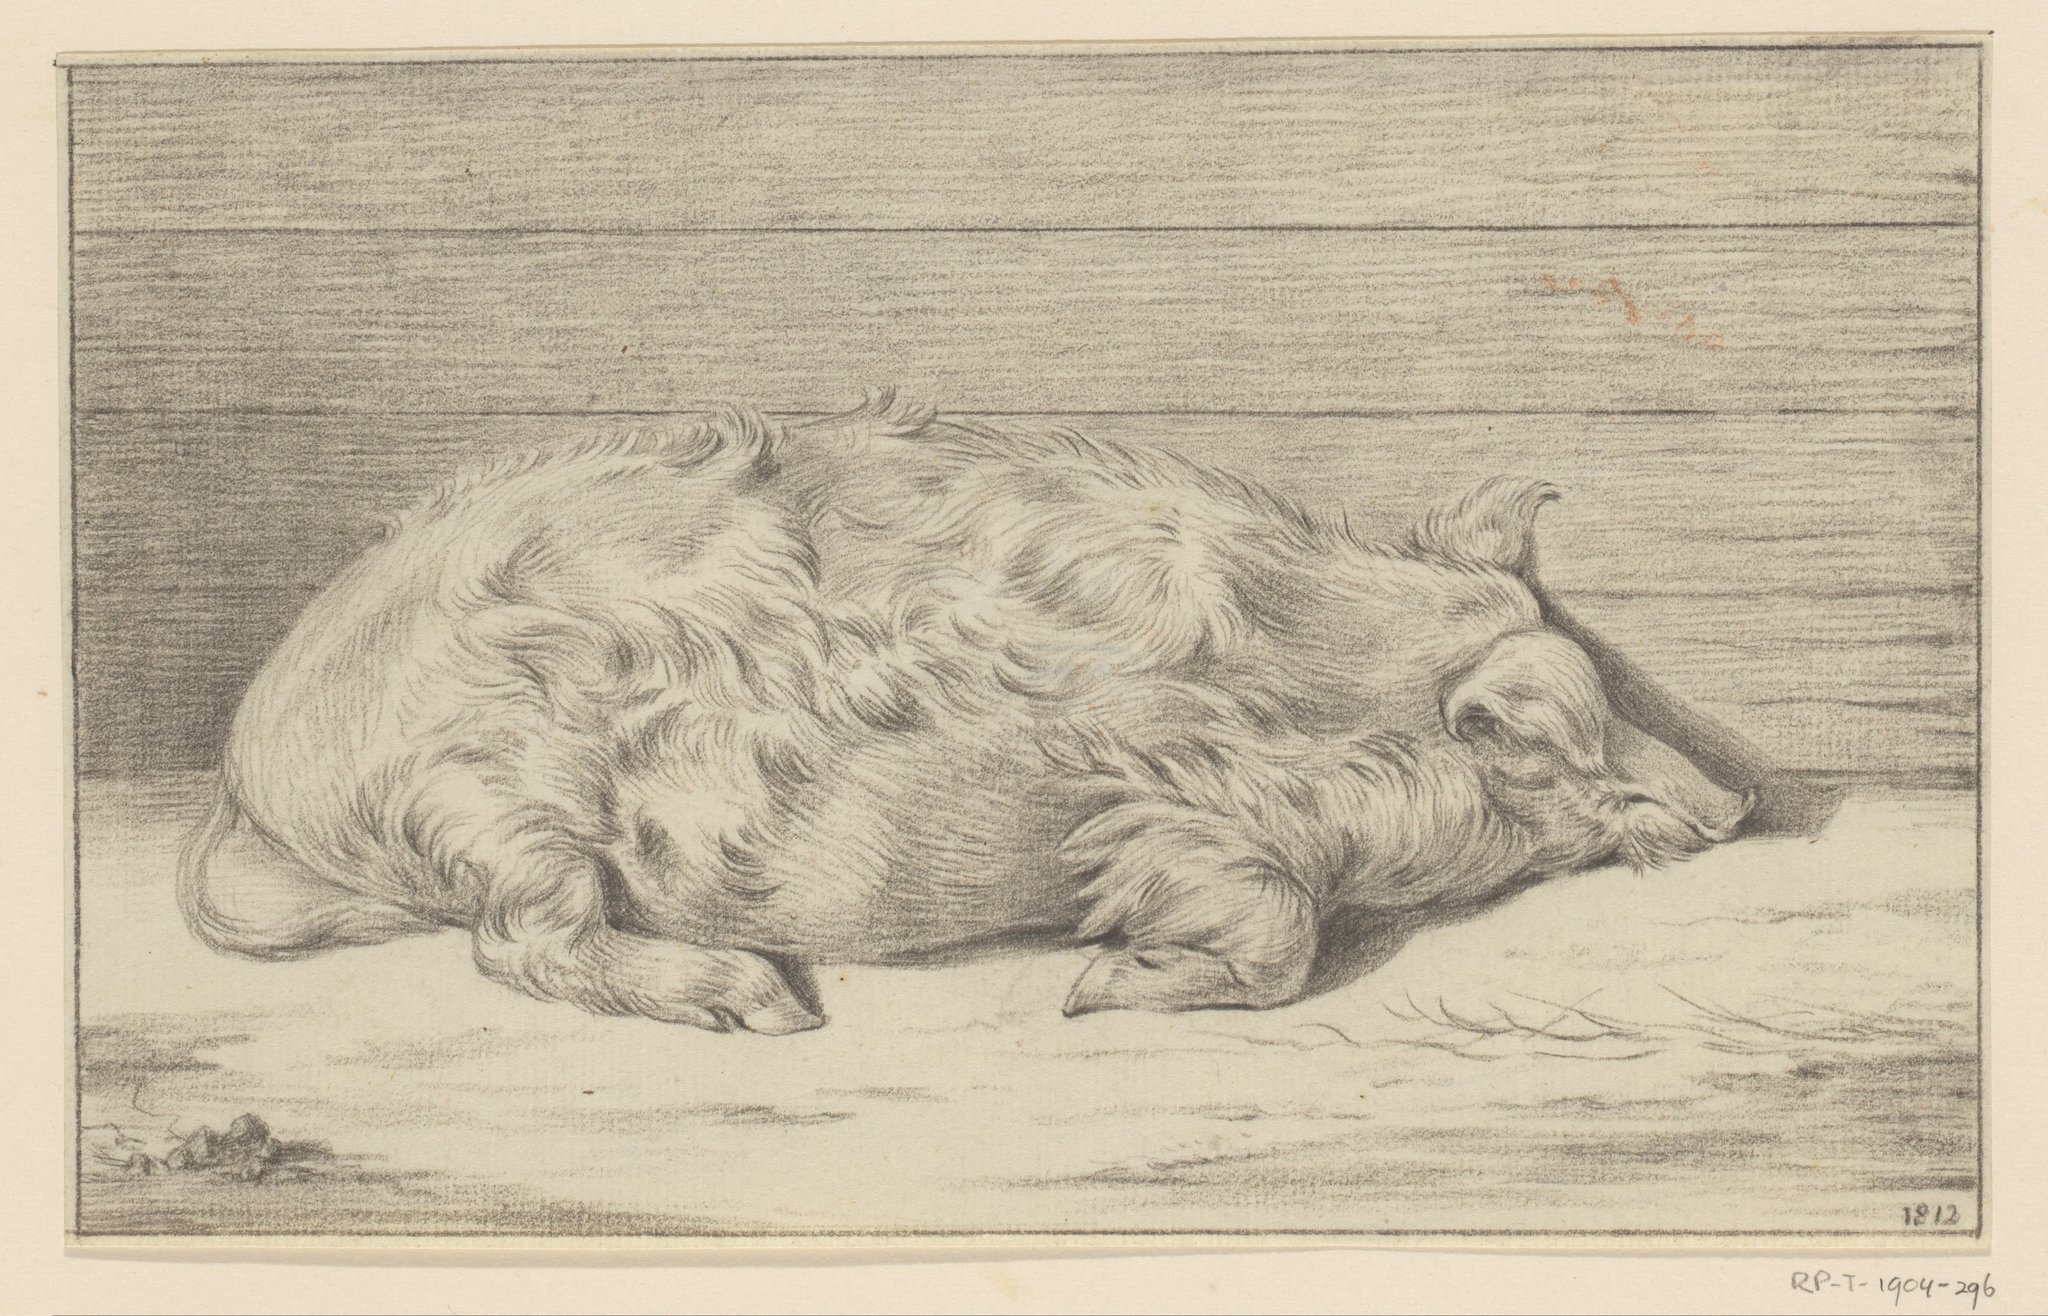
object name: drawing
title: Liggend varken, naar rechts, tegen een beschutting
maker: jean bernard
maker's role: draughtsman, print maker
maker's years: 1765-1833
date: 1812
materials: chalk, paper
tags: pig